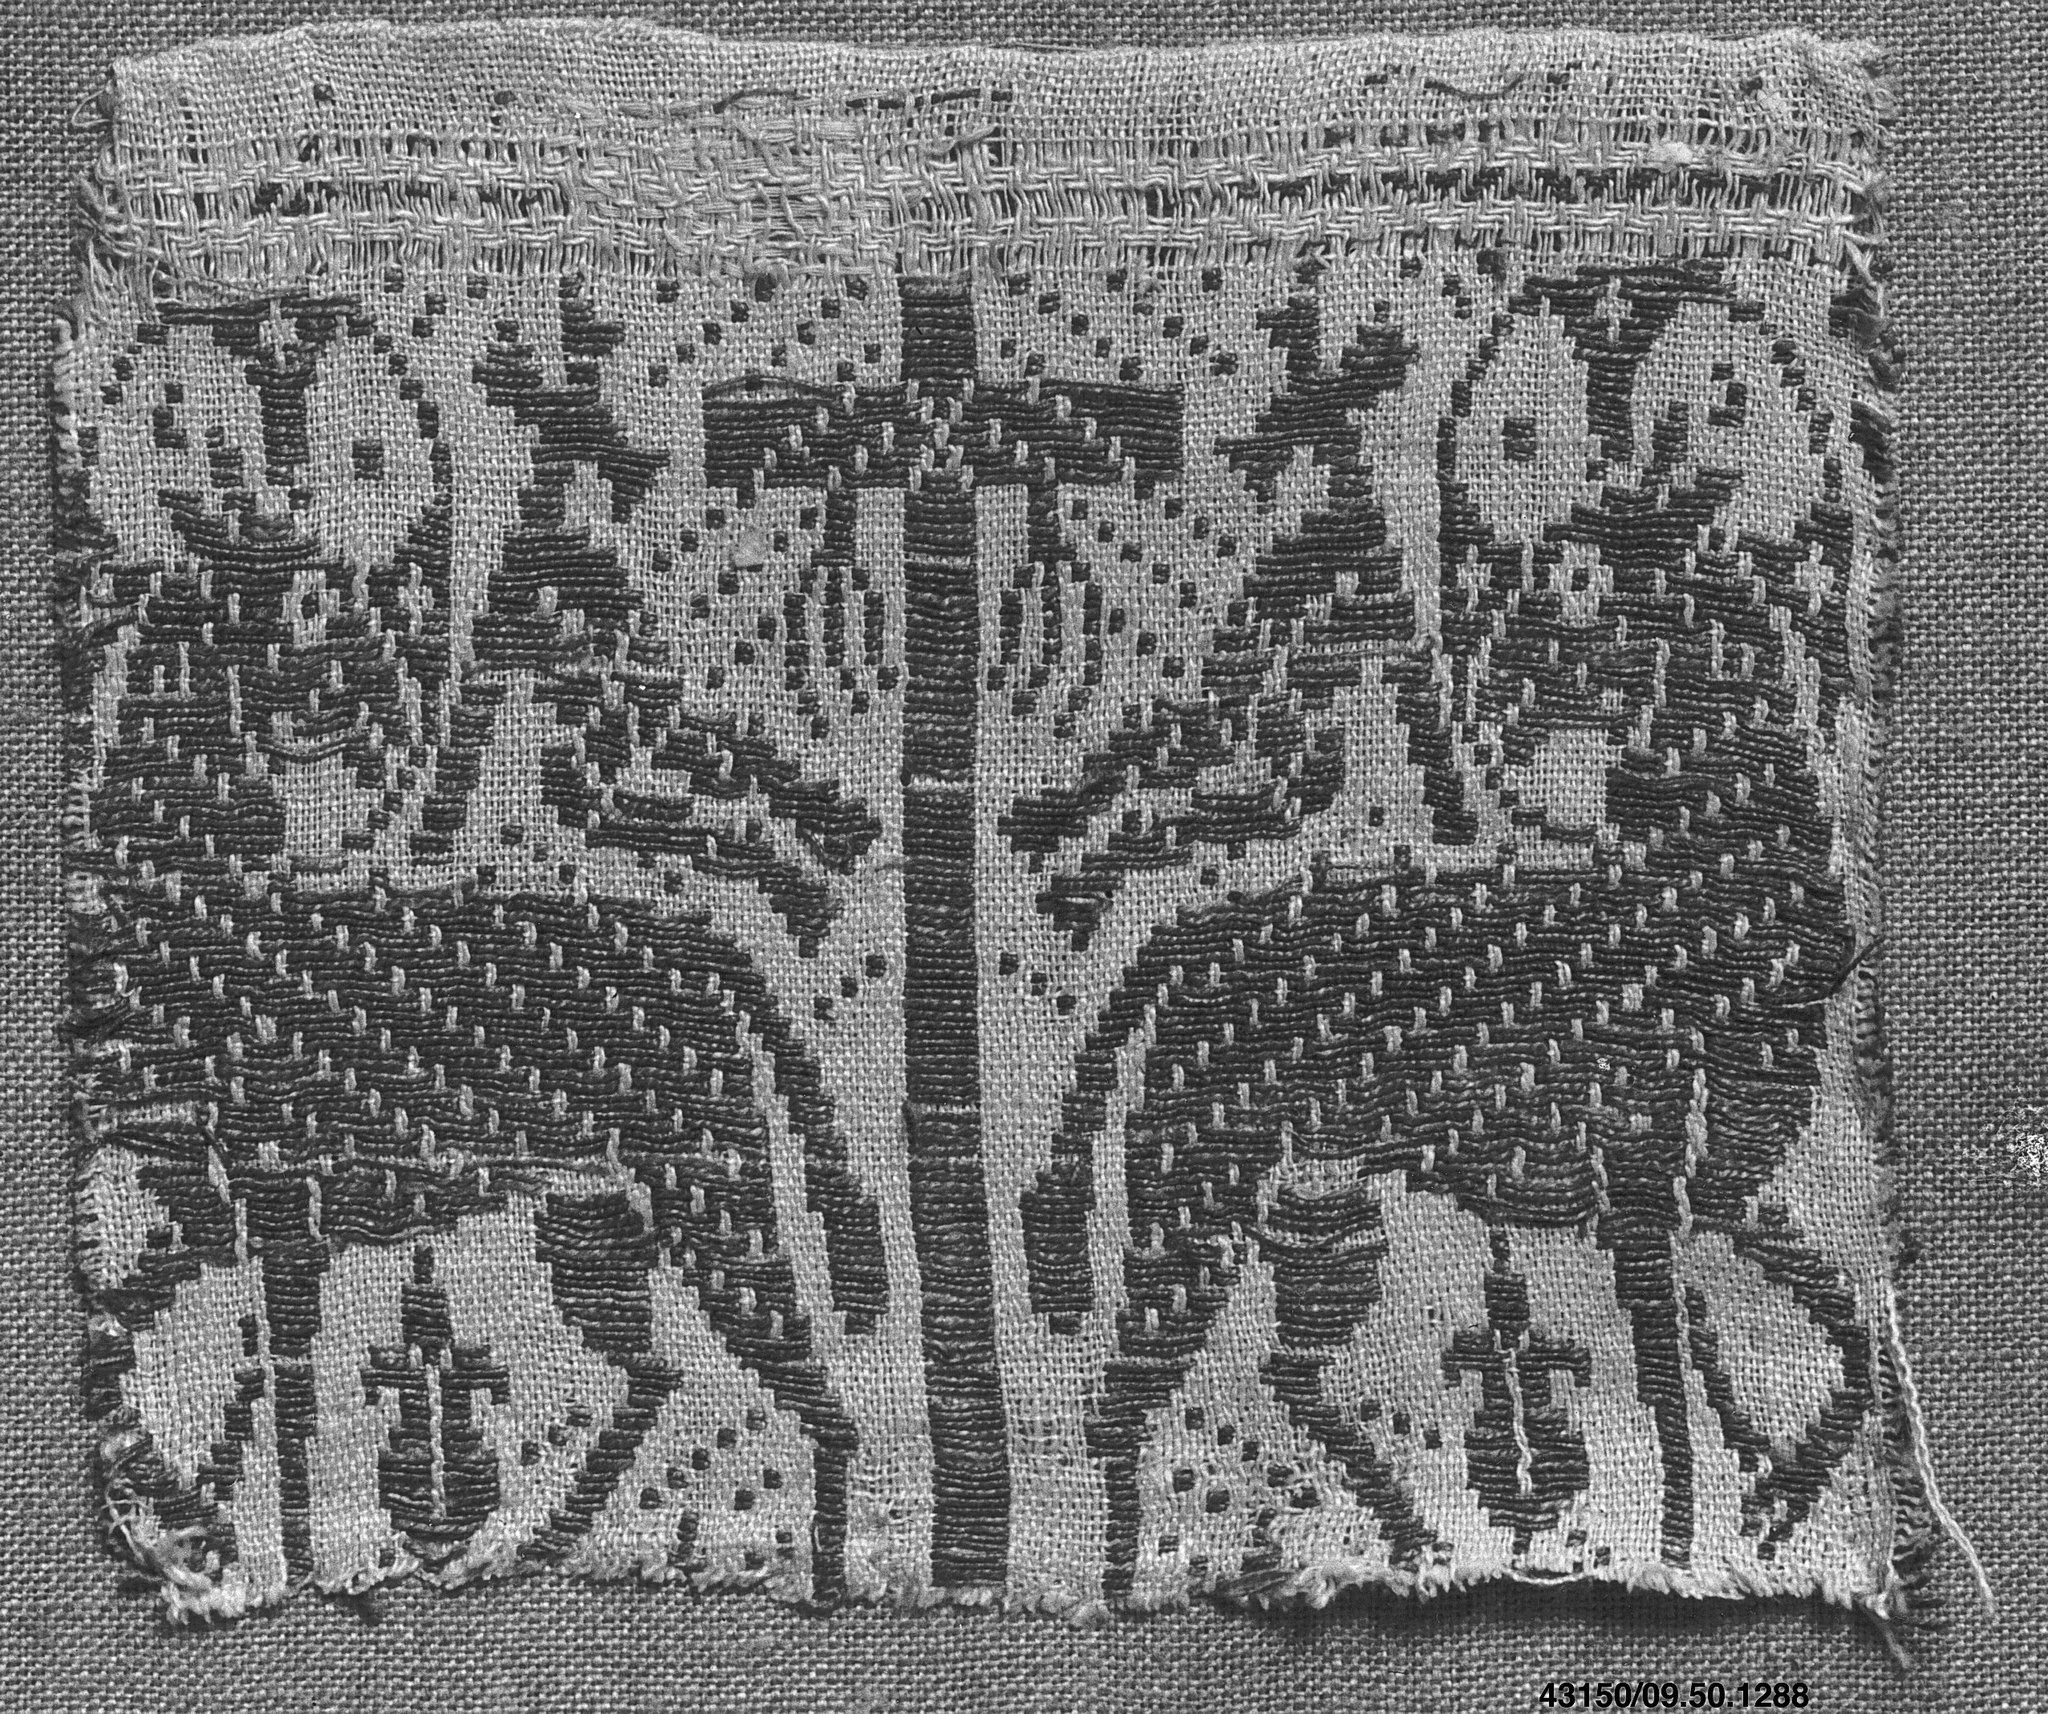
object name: piece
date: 1567-1633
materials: cotton, linen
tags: animals,cross